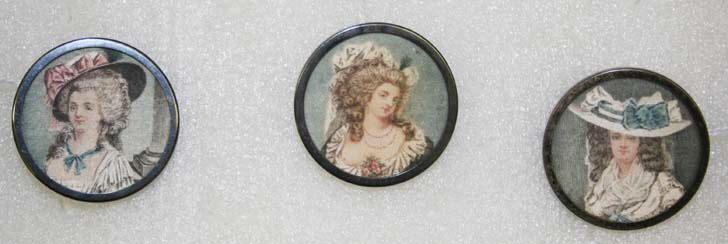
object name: button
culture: french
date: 1780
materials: glass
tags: portraits,women